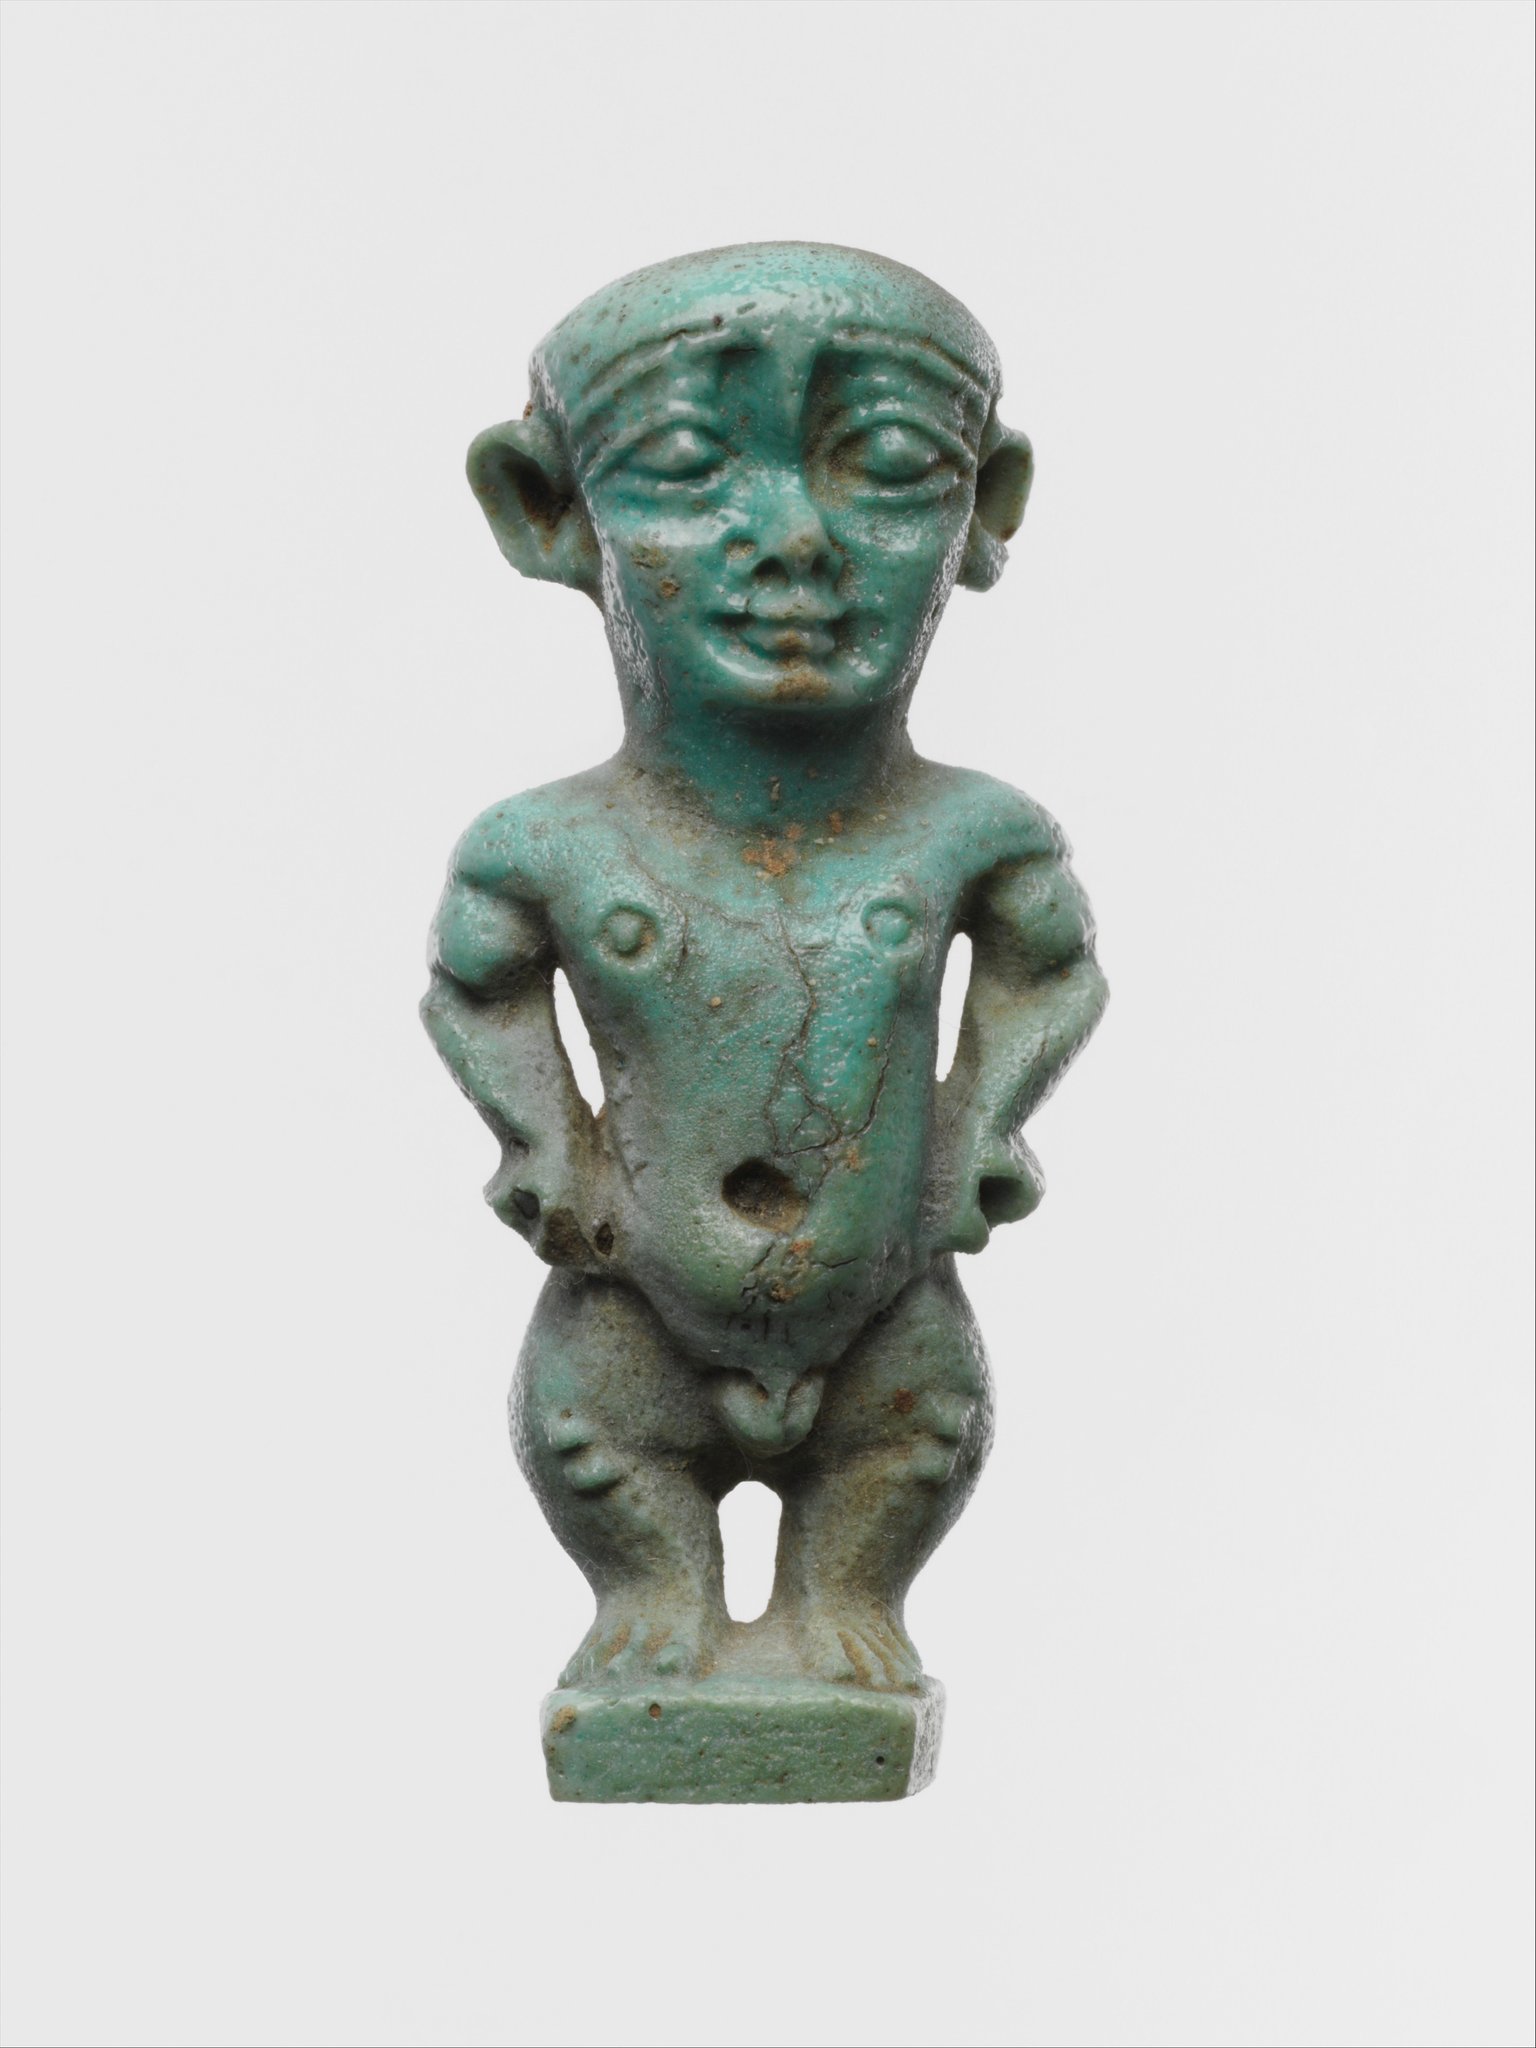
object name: amulet, ptah seker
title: Faience amulet in the form of the dwarf god Pataikos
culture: egyptian, ptolemaic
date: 664-630 BCE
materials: clay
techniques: glazing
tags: male nudes,gods